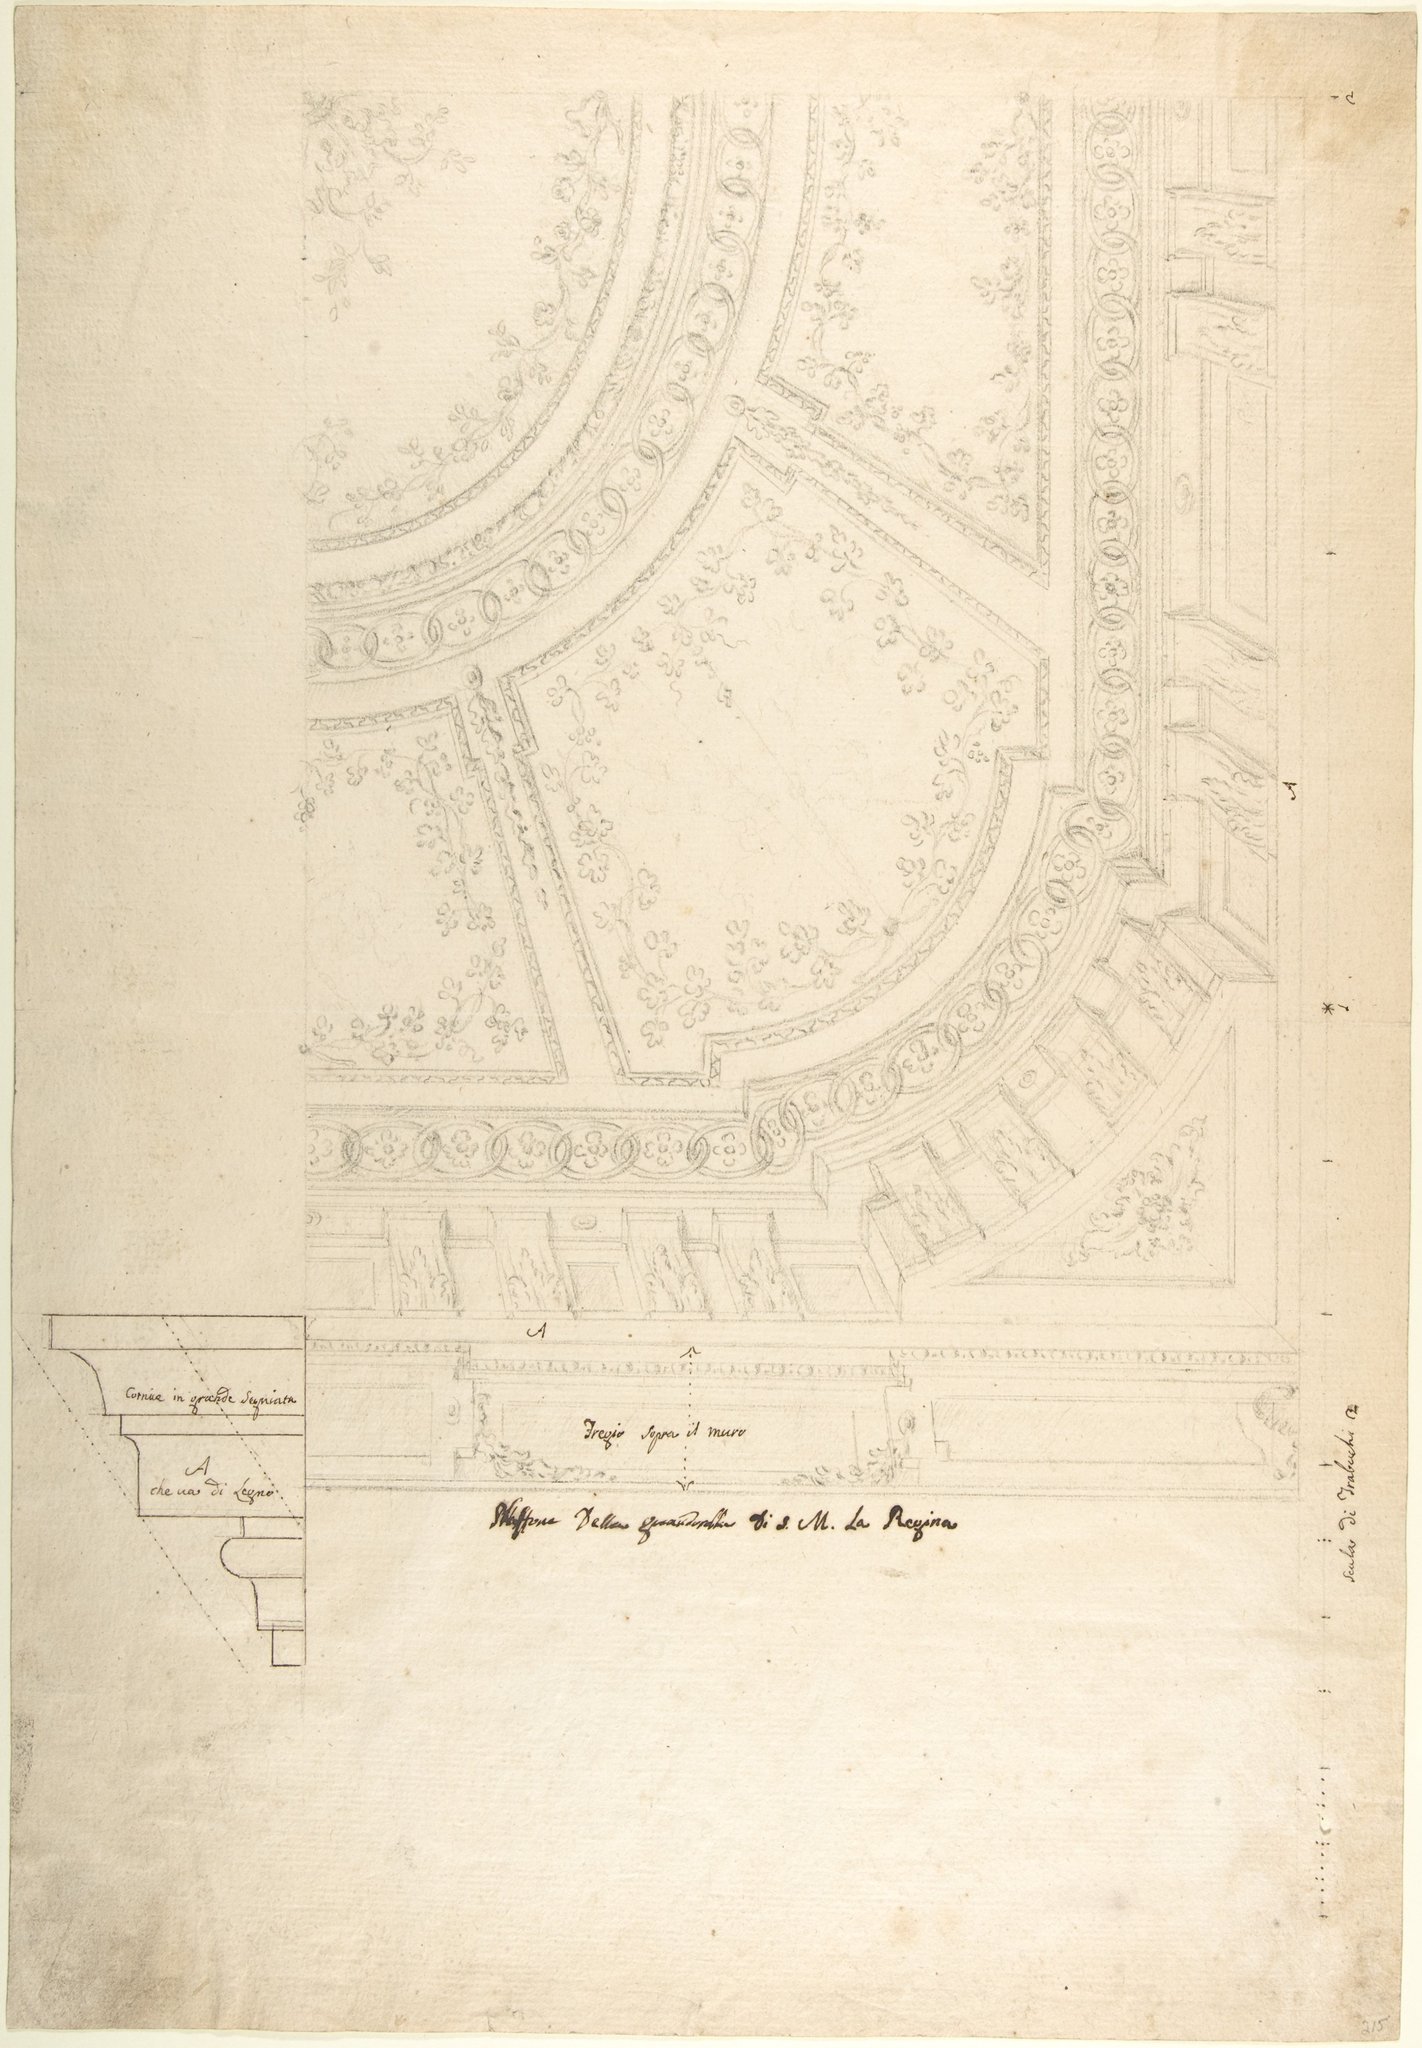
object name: drawing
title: Design for a Ceiling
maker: leonardo marini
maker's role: artist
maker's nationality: italian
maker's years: 1730-1797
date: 1774-1778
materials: graphite, ink, drawing material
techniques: pen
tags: ornament